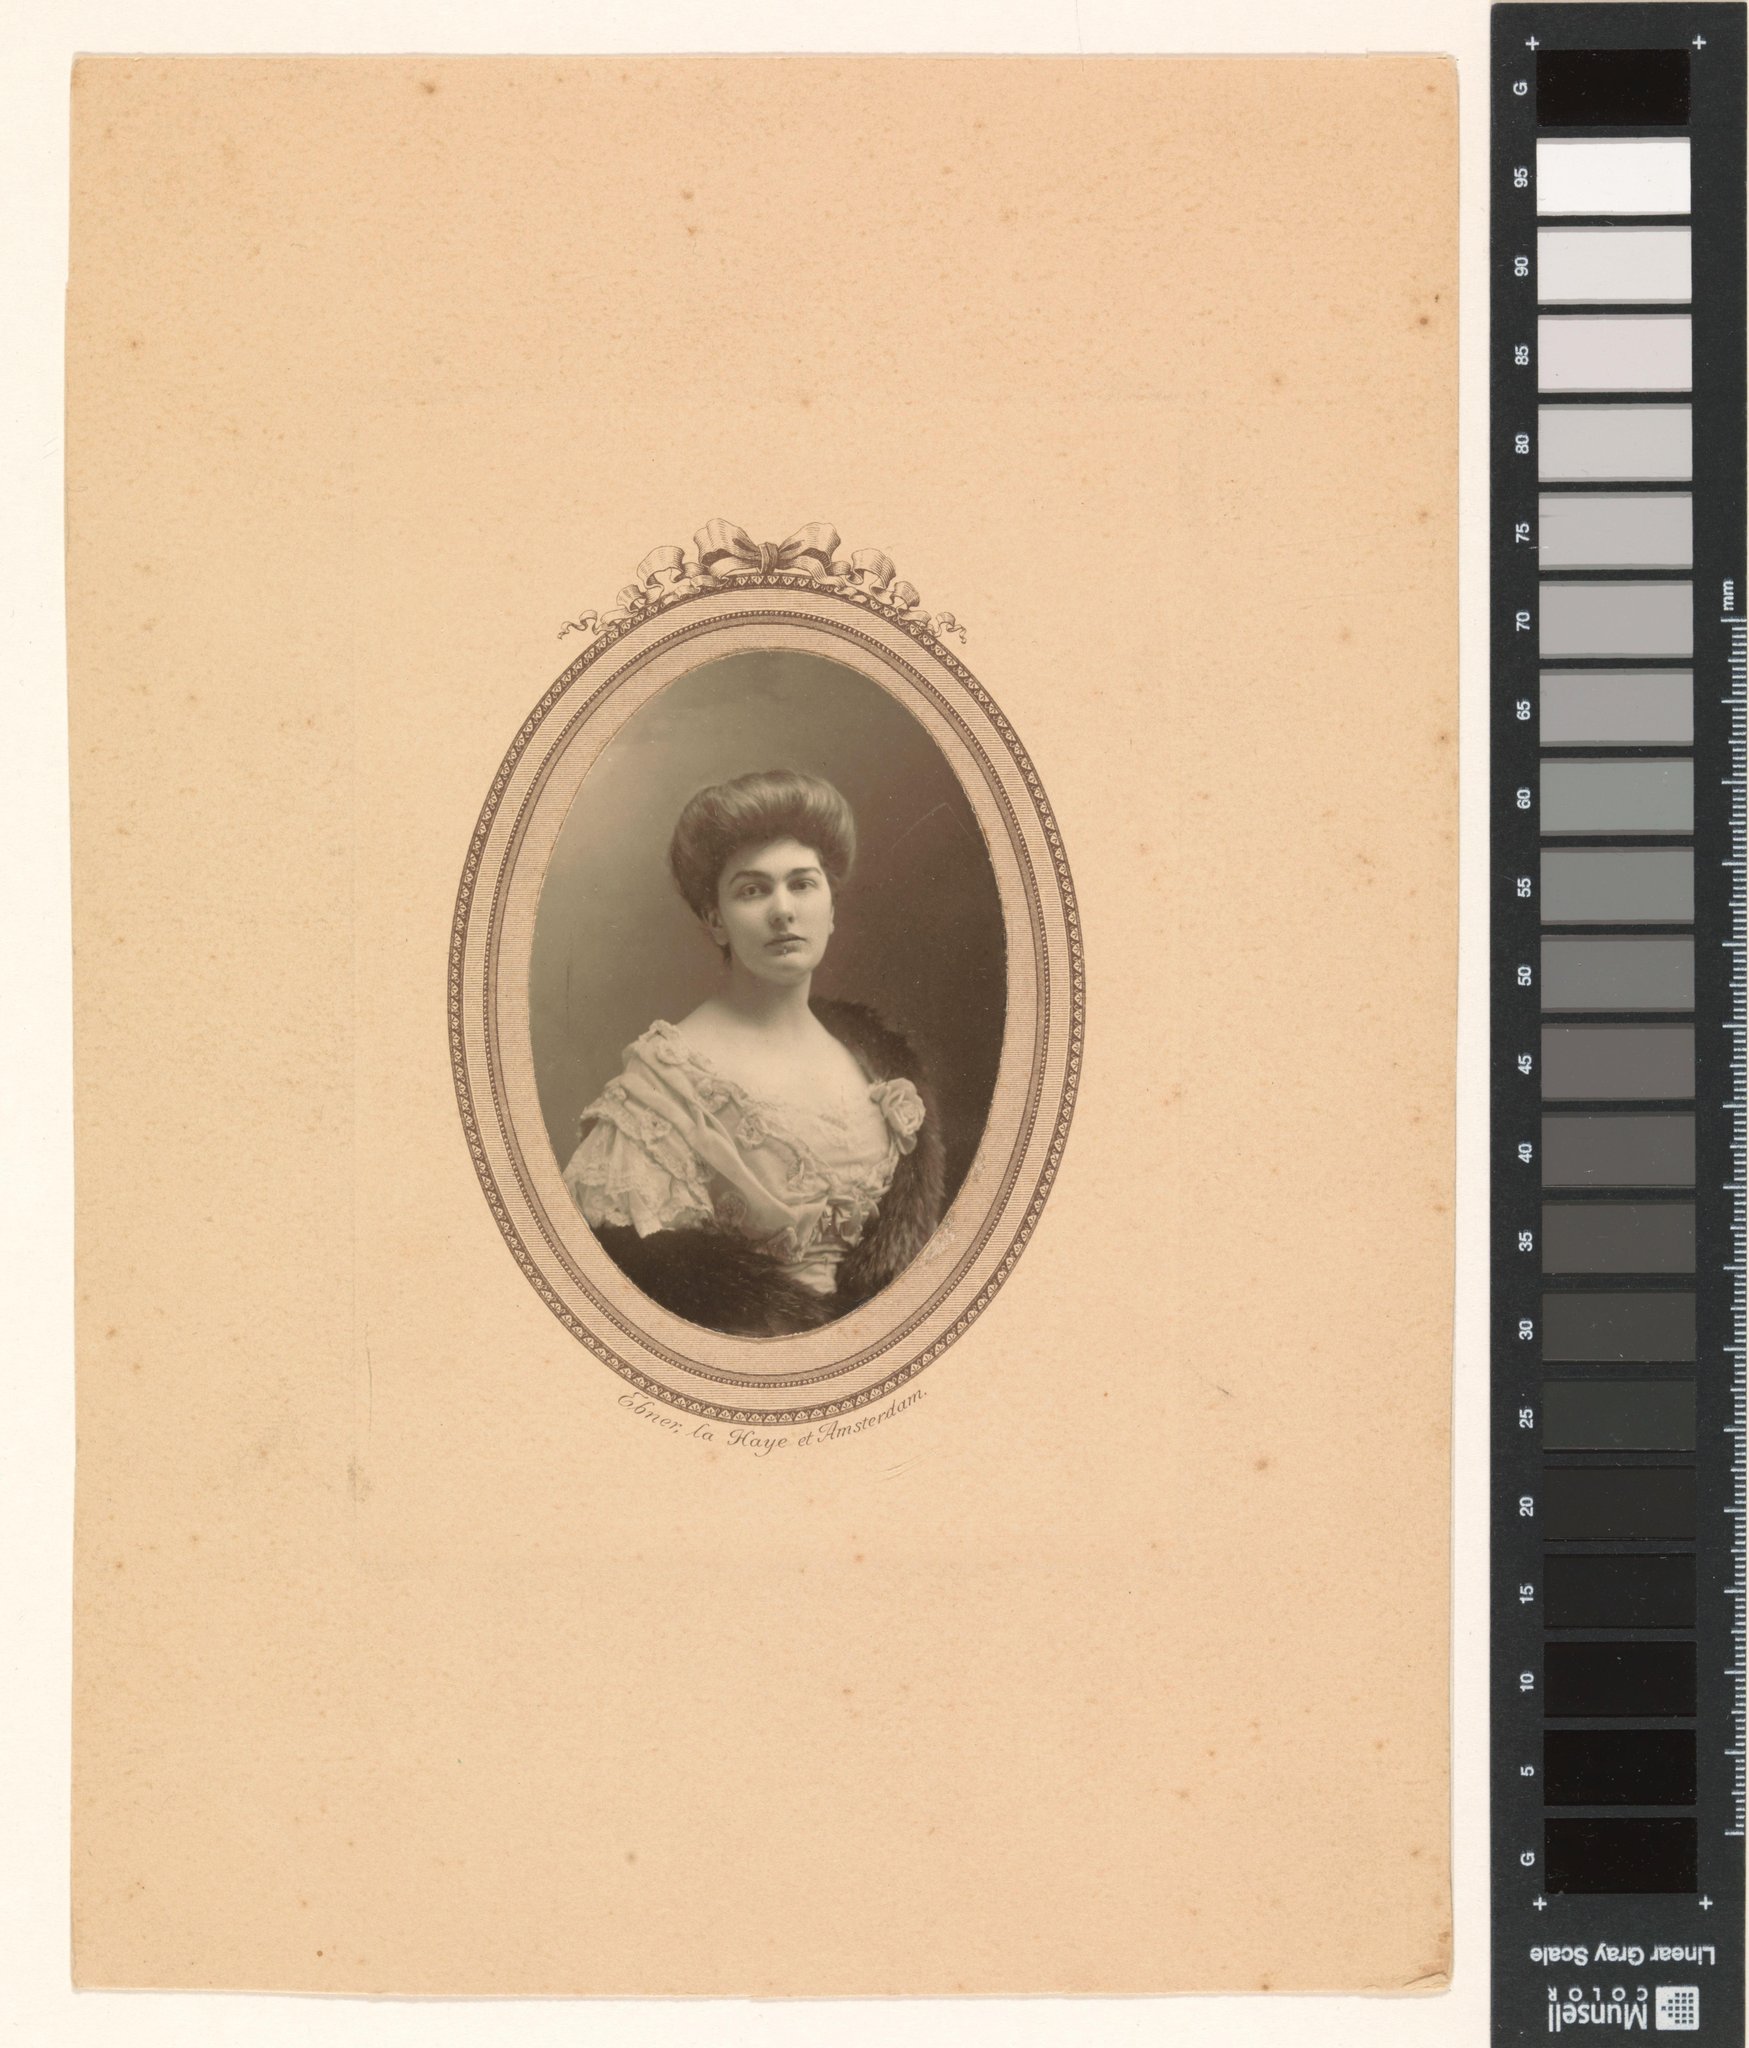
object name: photograph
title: Ovaal portret van Adeh van Braam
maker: ferdinand robert ebner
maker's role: fotograaf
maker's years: 1873-1919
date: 1880-1920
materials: cardboard, paper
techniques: matte daylight collodion silver print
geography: the hague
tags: arnhem, historical persons - bb - woman, netherlands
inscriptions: annotation: ‘Adeh van Braam’, signature: ‘Ebner, La Haye et Amsterdam’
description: De foto is geplakt in een ovale tekening die op deze maniet een lijst vormt om de foto heen